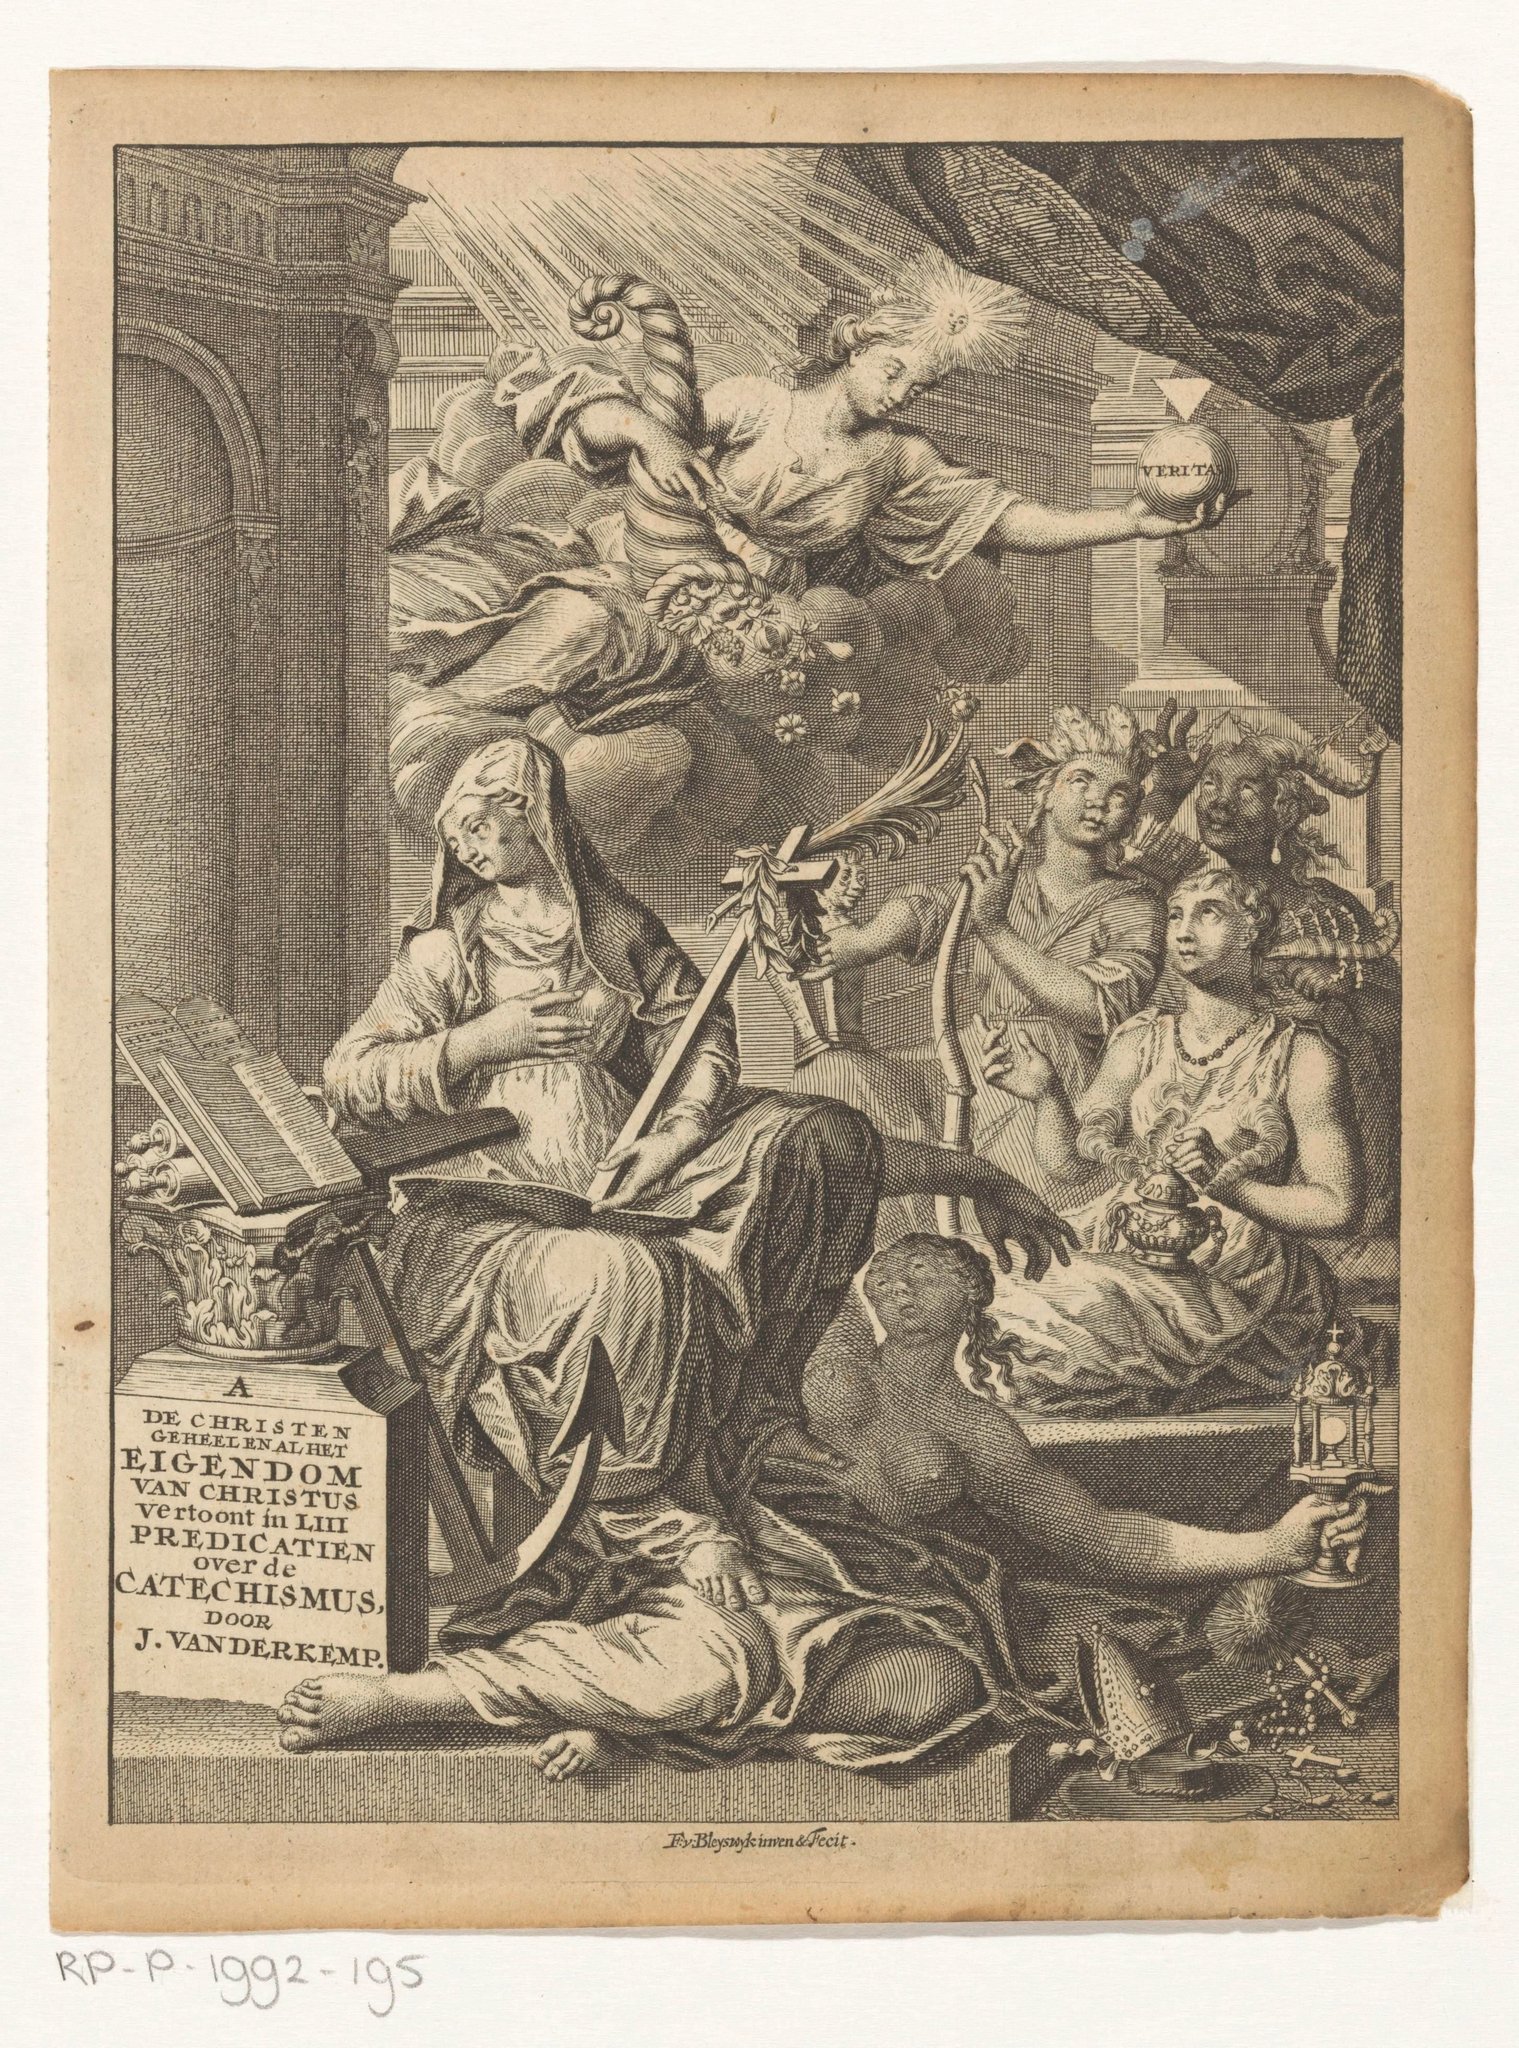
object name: print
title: Titelpagina voor: Johannes van der Kemp, De christen geheel en al het eigendom van Christus in leven en sterven, vertoont in drieenvyftig predikatien over den Heidelbergschen katechismus, 1736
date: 1736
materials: paper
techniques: engraving, etching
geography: rotterdam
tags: truth; 'verità' (ripa)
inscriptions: collector's mark: Lugt 2760, collector's mark: Lugt 2228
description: Titelpagina voor: Johannes van der Kemp, De christen geheel en al het eigendom van Christus in leven en sterven, vertoont in drieenvyftig predikatien over den Heidelbergschen katechismus, 1736